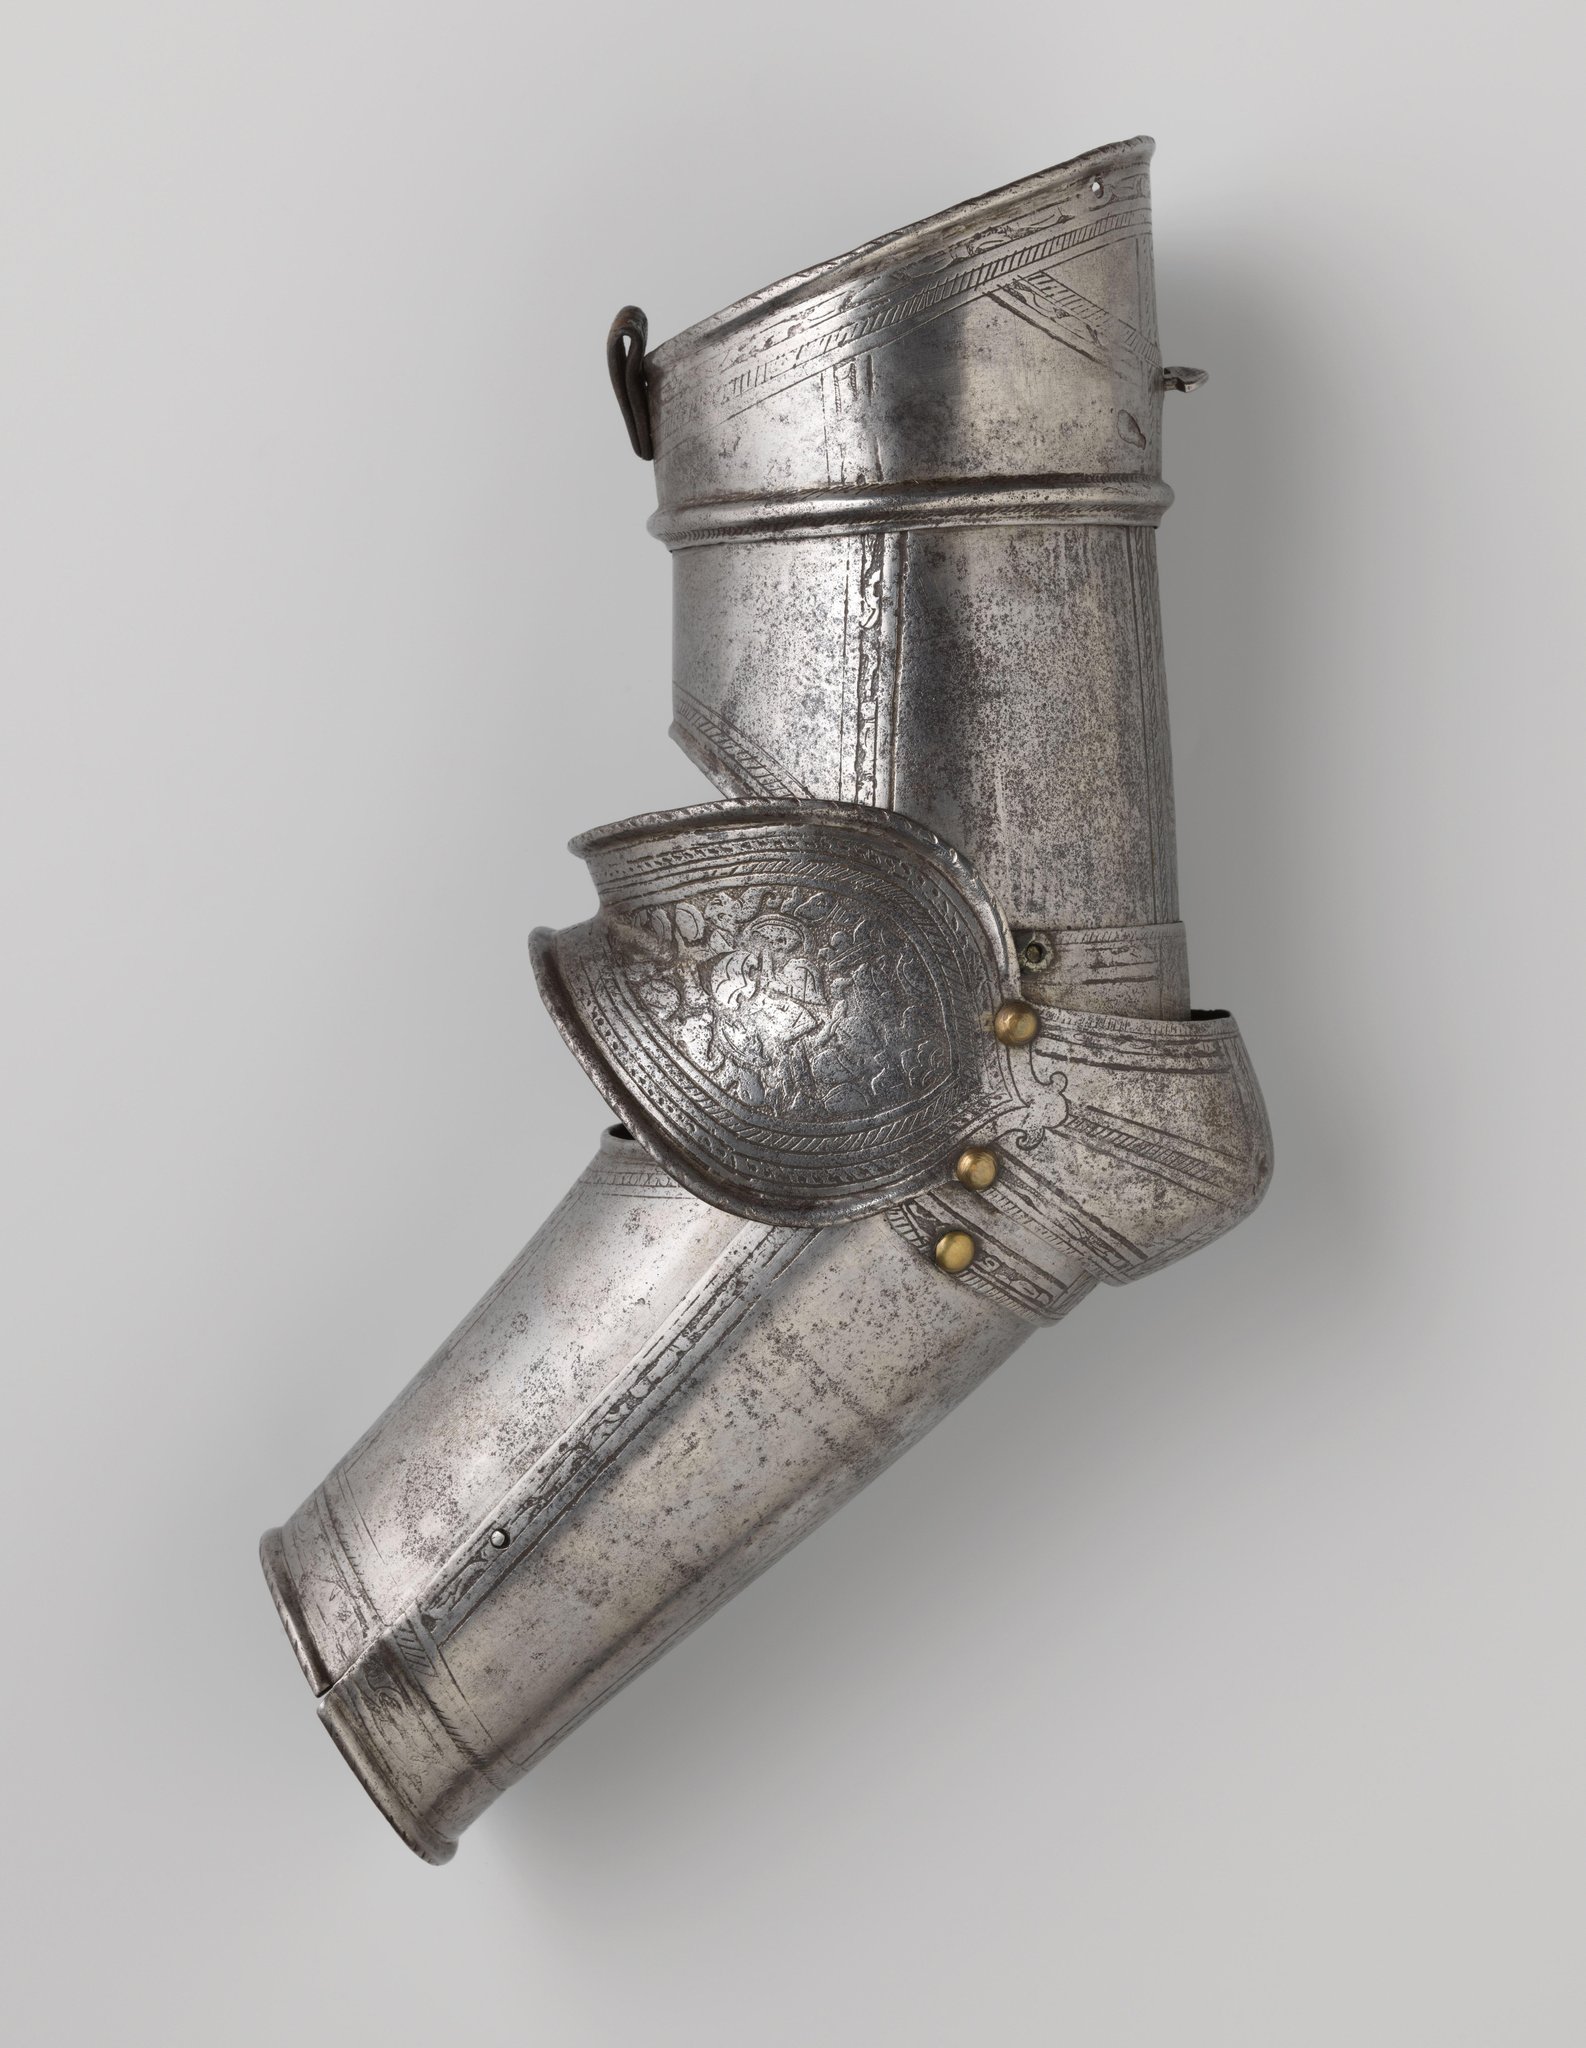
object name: harnasonderdeel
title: Armharnas voor linkerarm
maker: Anonymous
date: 1525-1575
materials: copper, leather, metal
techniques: etching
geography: europe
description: Armbedekking, armharnas voor linkerarm, ijzer, blank, bestaat uit een bovenarmpijp, een elleboogpijp en een onderarmpijp. De randen zijn omgeflenst. Op de bovenarmpijp een puntige pin en een leren riem. Er zijn rondom de bovenarmpijp versieringen aangebracht in een brede strook die naar beneden loopt. De elleboogpijp is versierd en aan de bovenarmpijp en de onderarmpijp vastgeklonken met geelkoperen klinknagels. Op de onderarmpijp zijn twee scharnieren aangebracht waardoor het onderstuk verwijderd kan worden. Vanaf de elleboogpijp een brede strook met versieringen naar de onderarmpijp. Binnenkant is zwart geverfd.